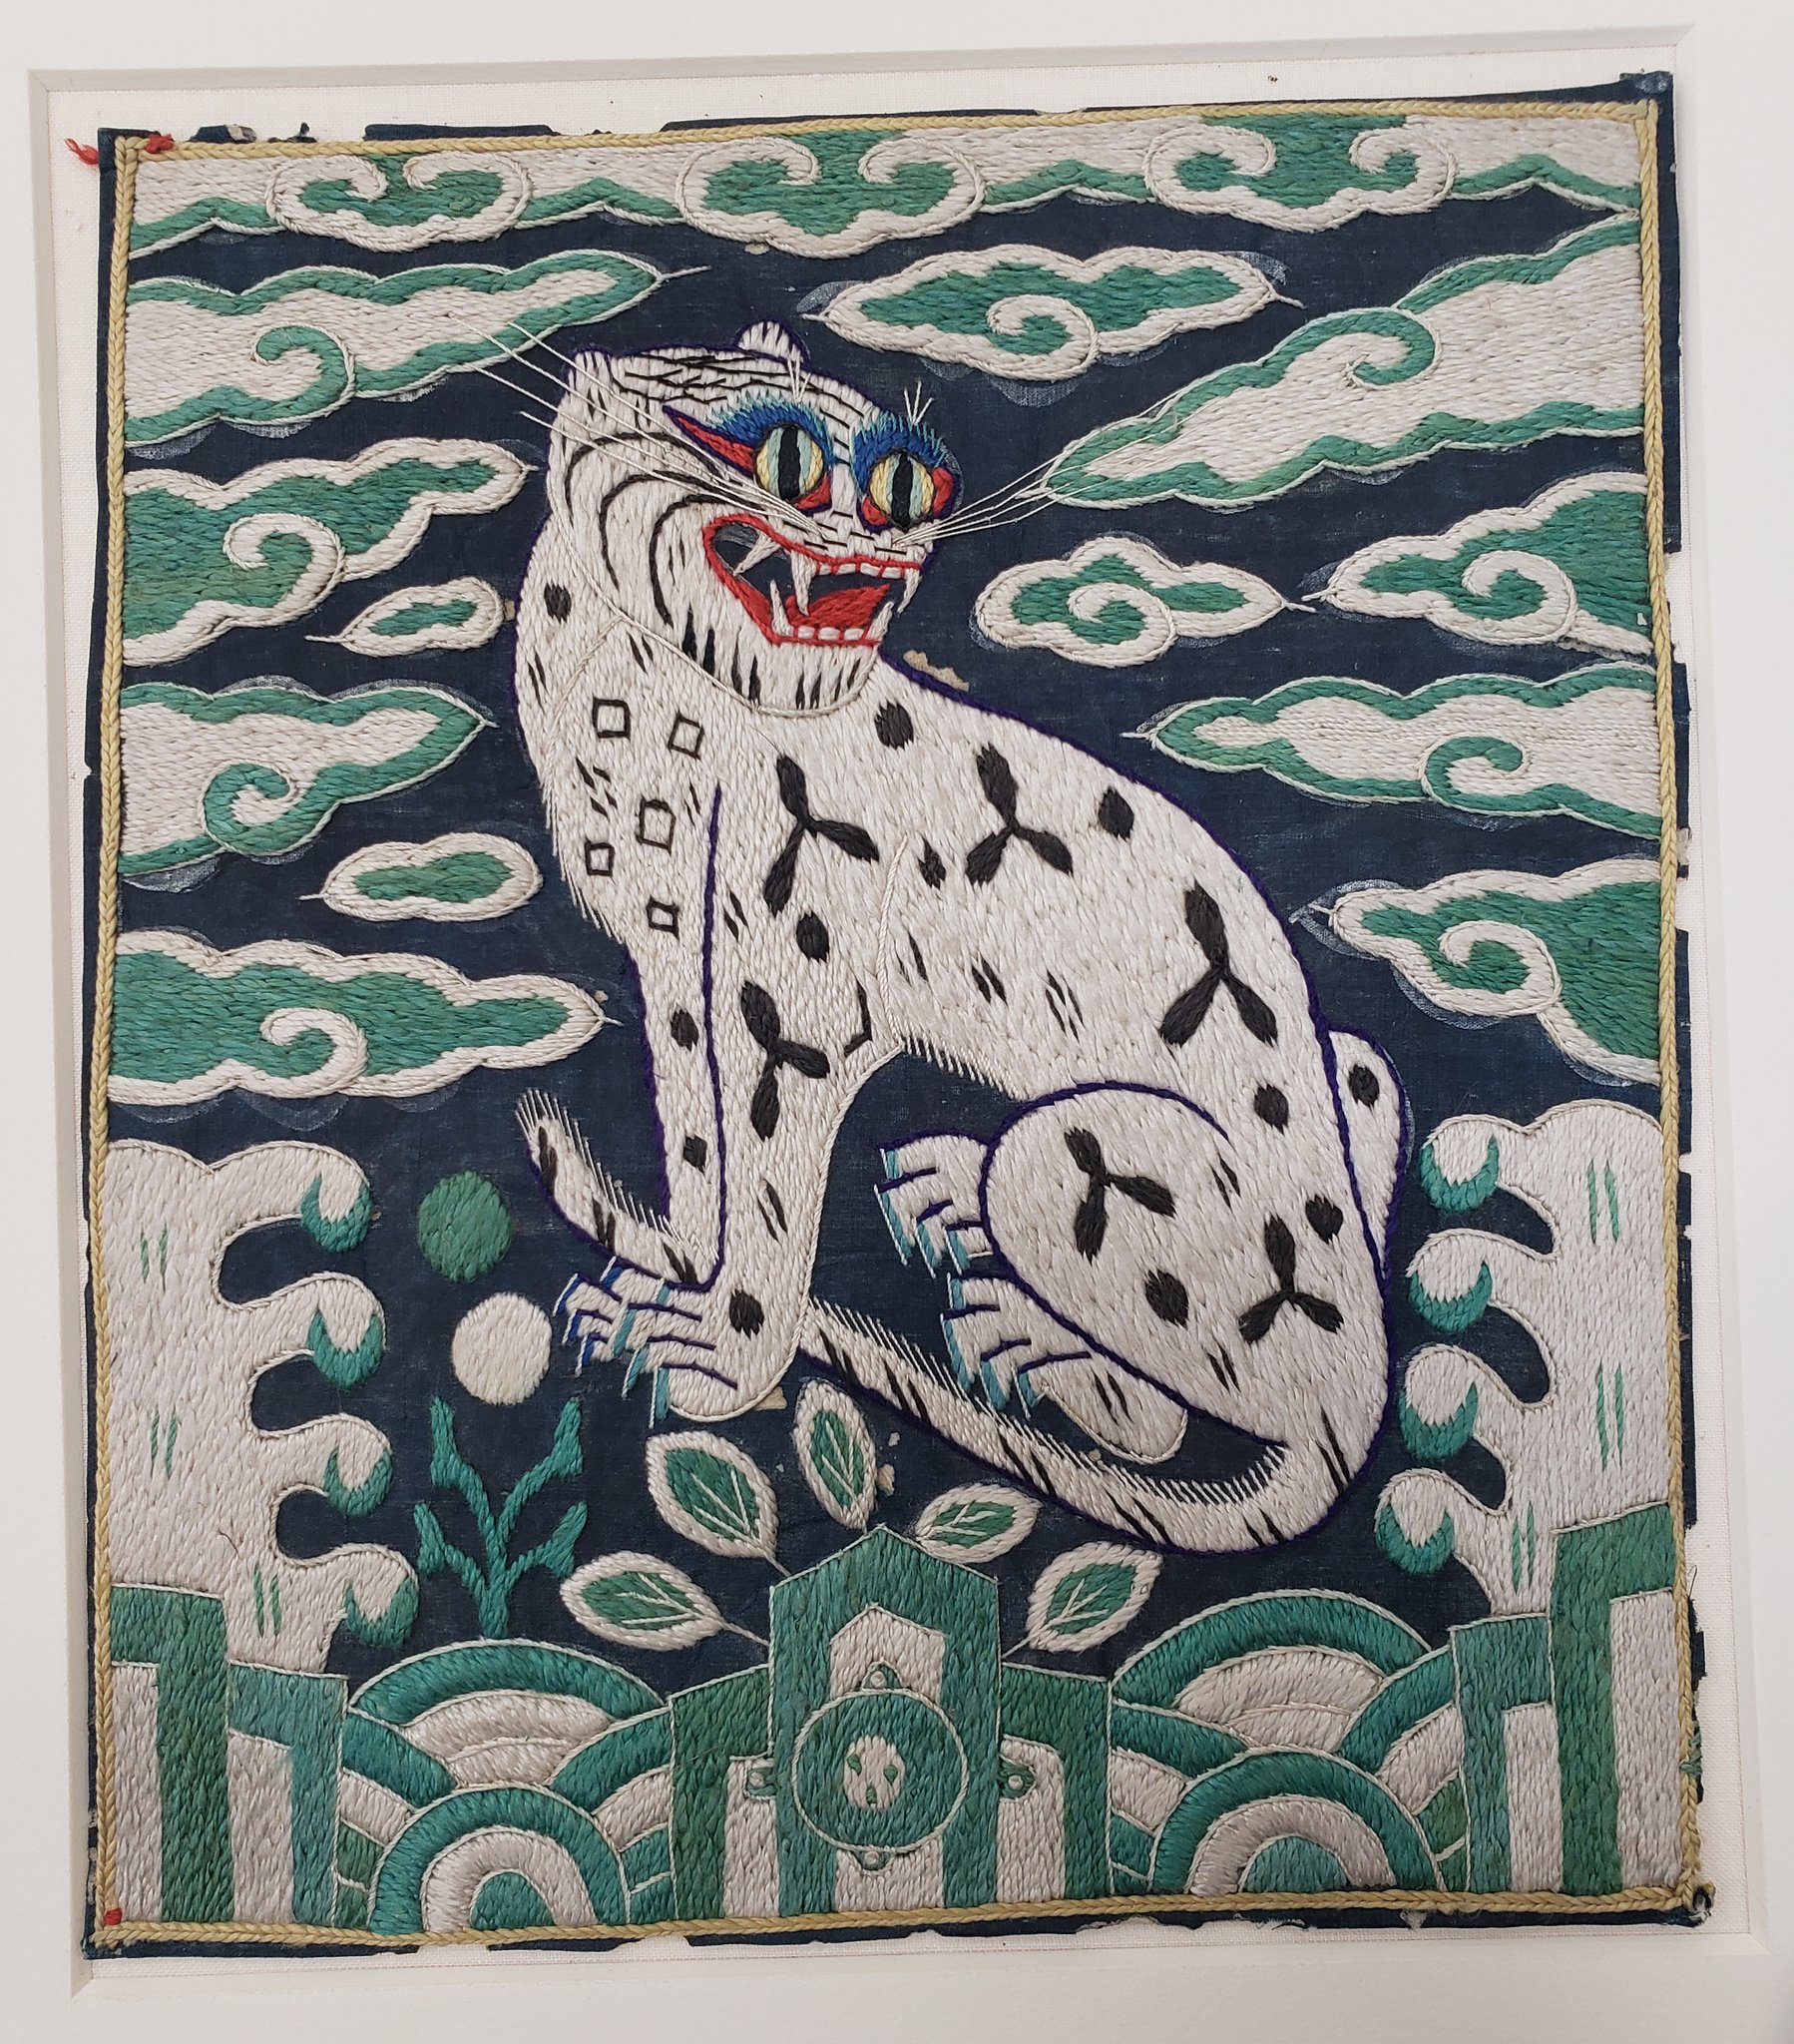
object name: rank badge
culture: korean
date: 1392-1910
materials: silk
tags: leopards